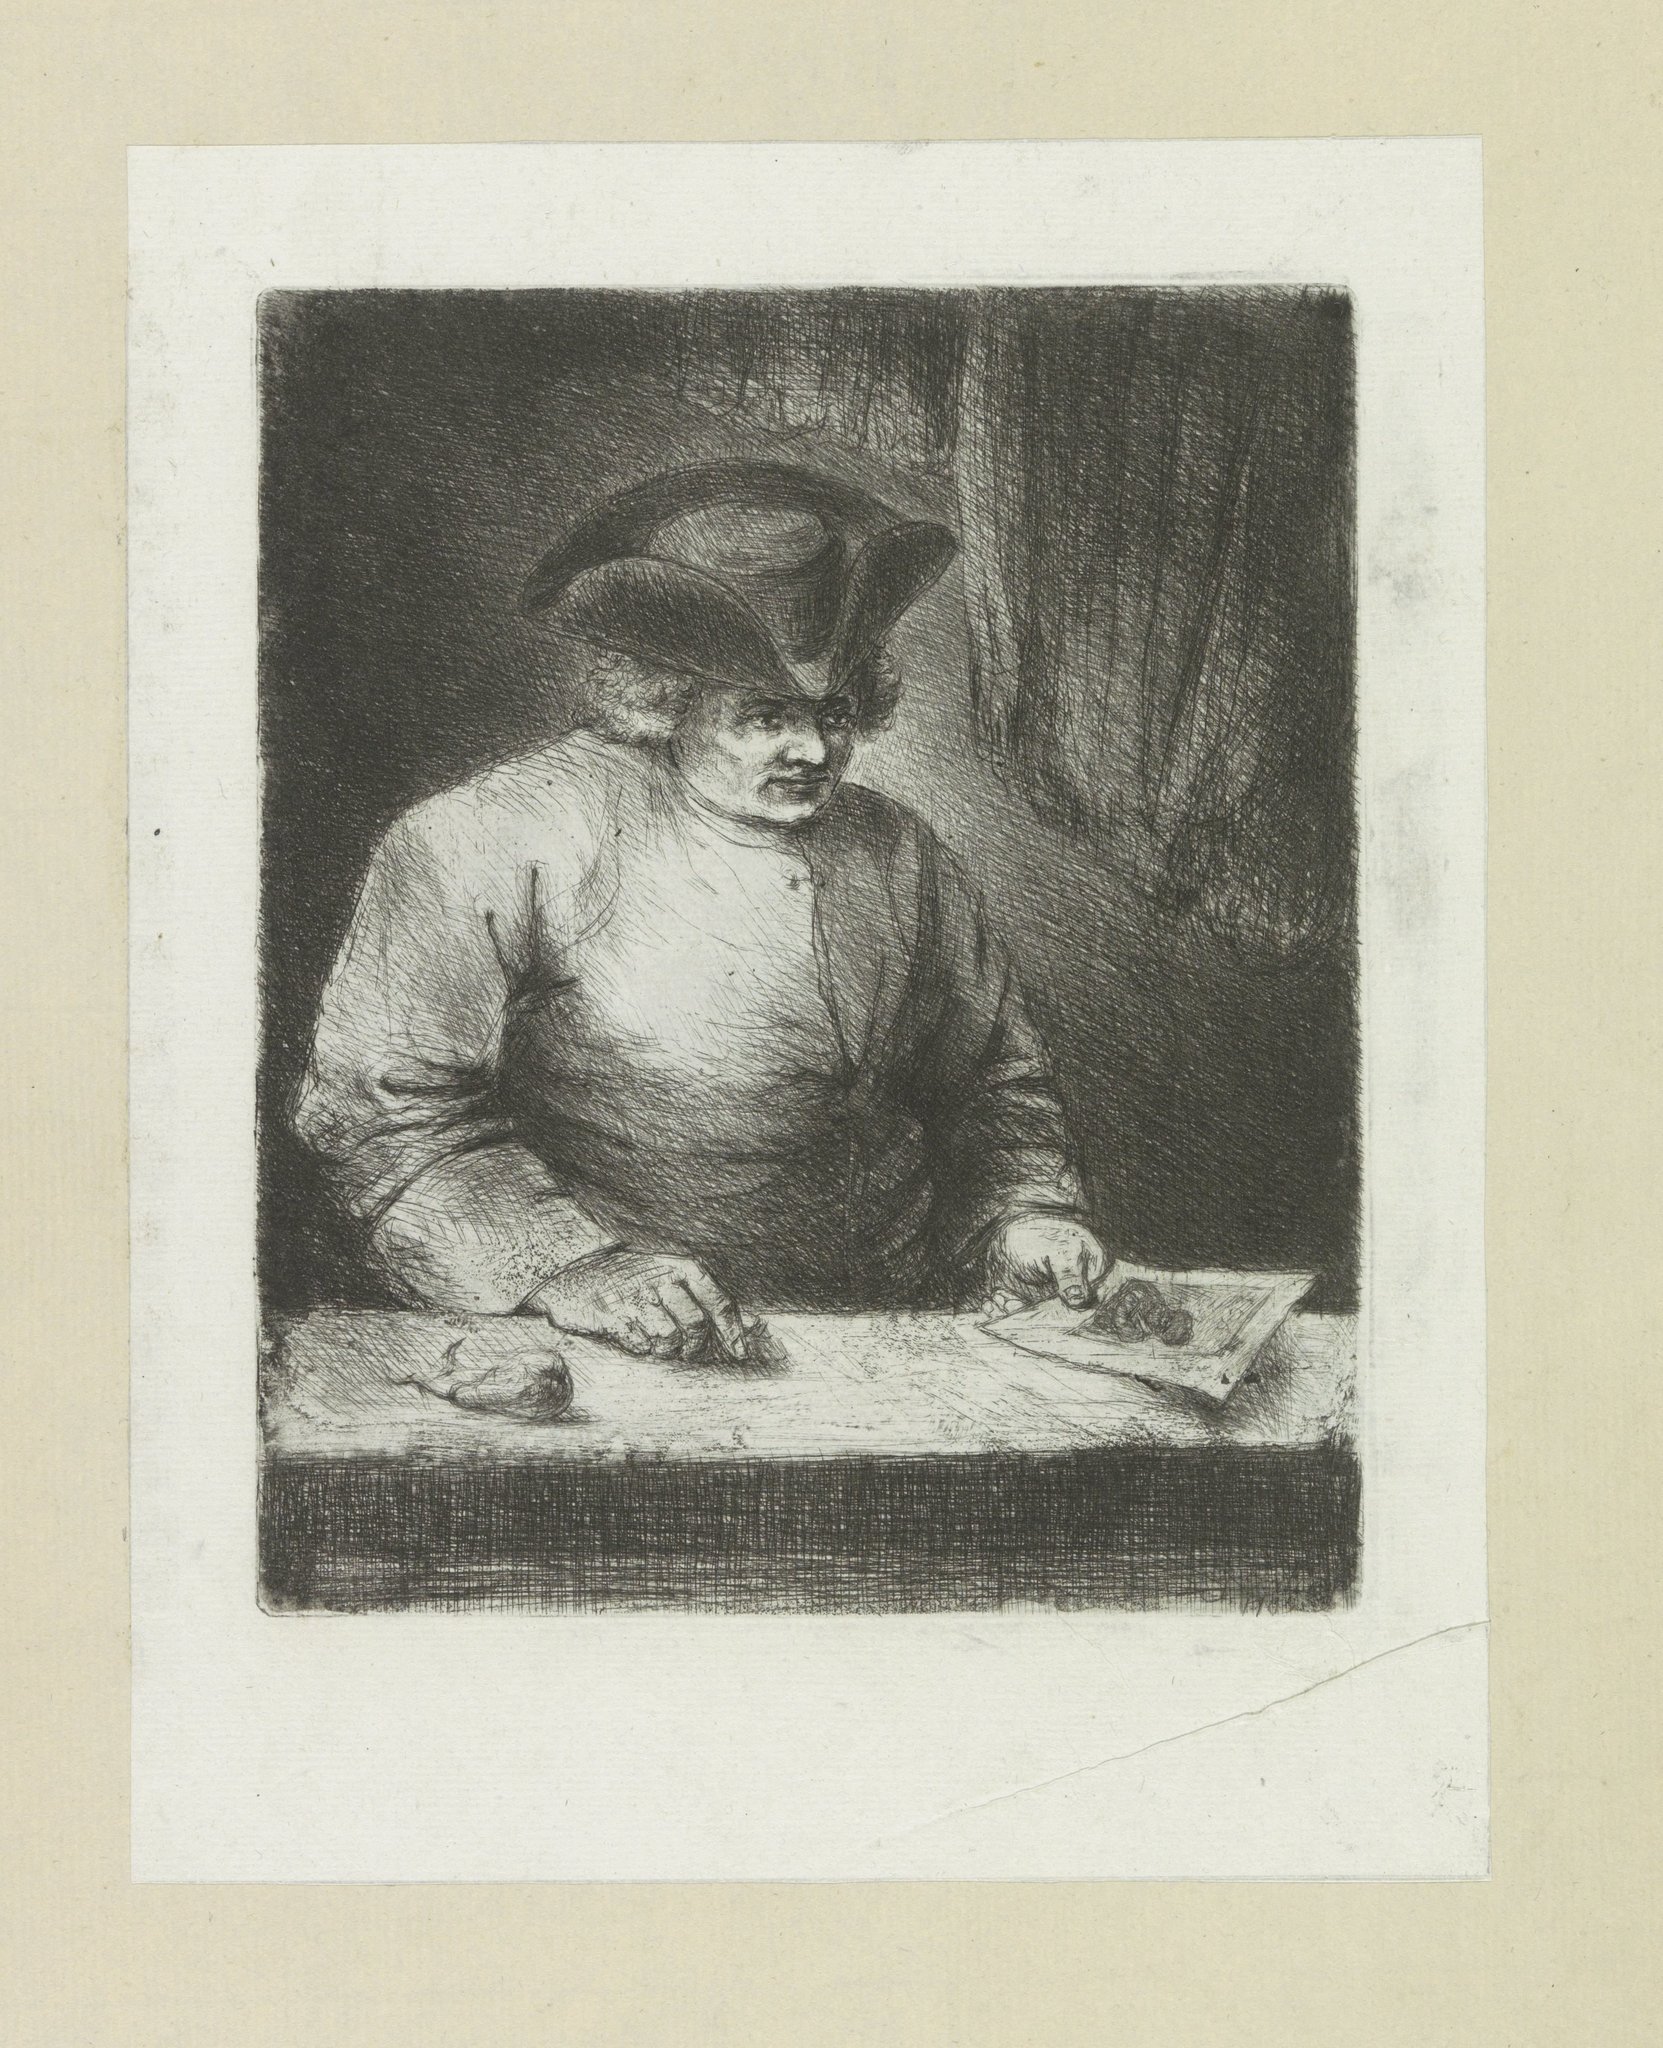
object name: album leaf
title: Portret van Hendrik Chalon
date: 1789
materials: paper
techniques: drypoint, etching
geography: london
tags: leiden, draughtsman, hendrik chalon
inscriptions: collector's mark: ‘RIJKS / MUSM’, collector's mark: ‘B’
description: Portret van Hendrik Chalon, tekenaar en vader van de prentmaker. Hendrik staat met buste naar rechts voor een tafel en bestudeert een prent die hij in zijn linkerhand houdt. op zijn hoofd draagt hij een steek. Links op de tafel ligt een peer. De prent maakt deel uit van een album.